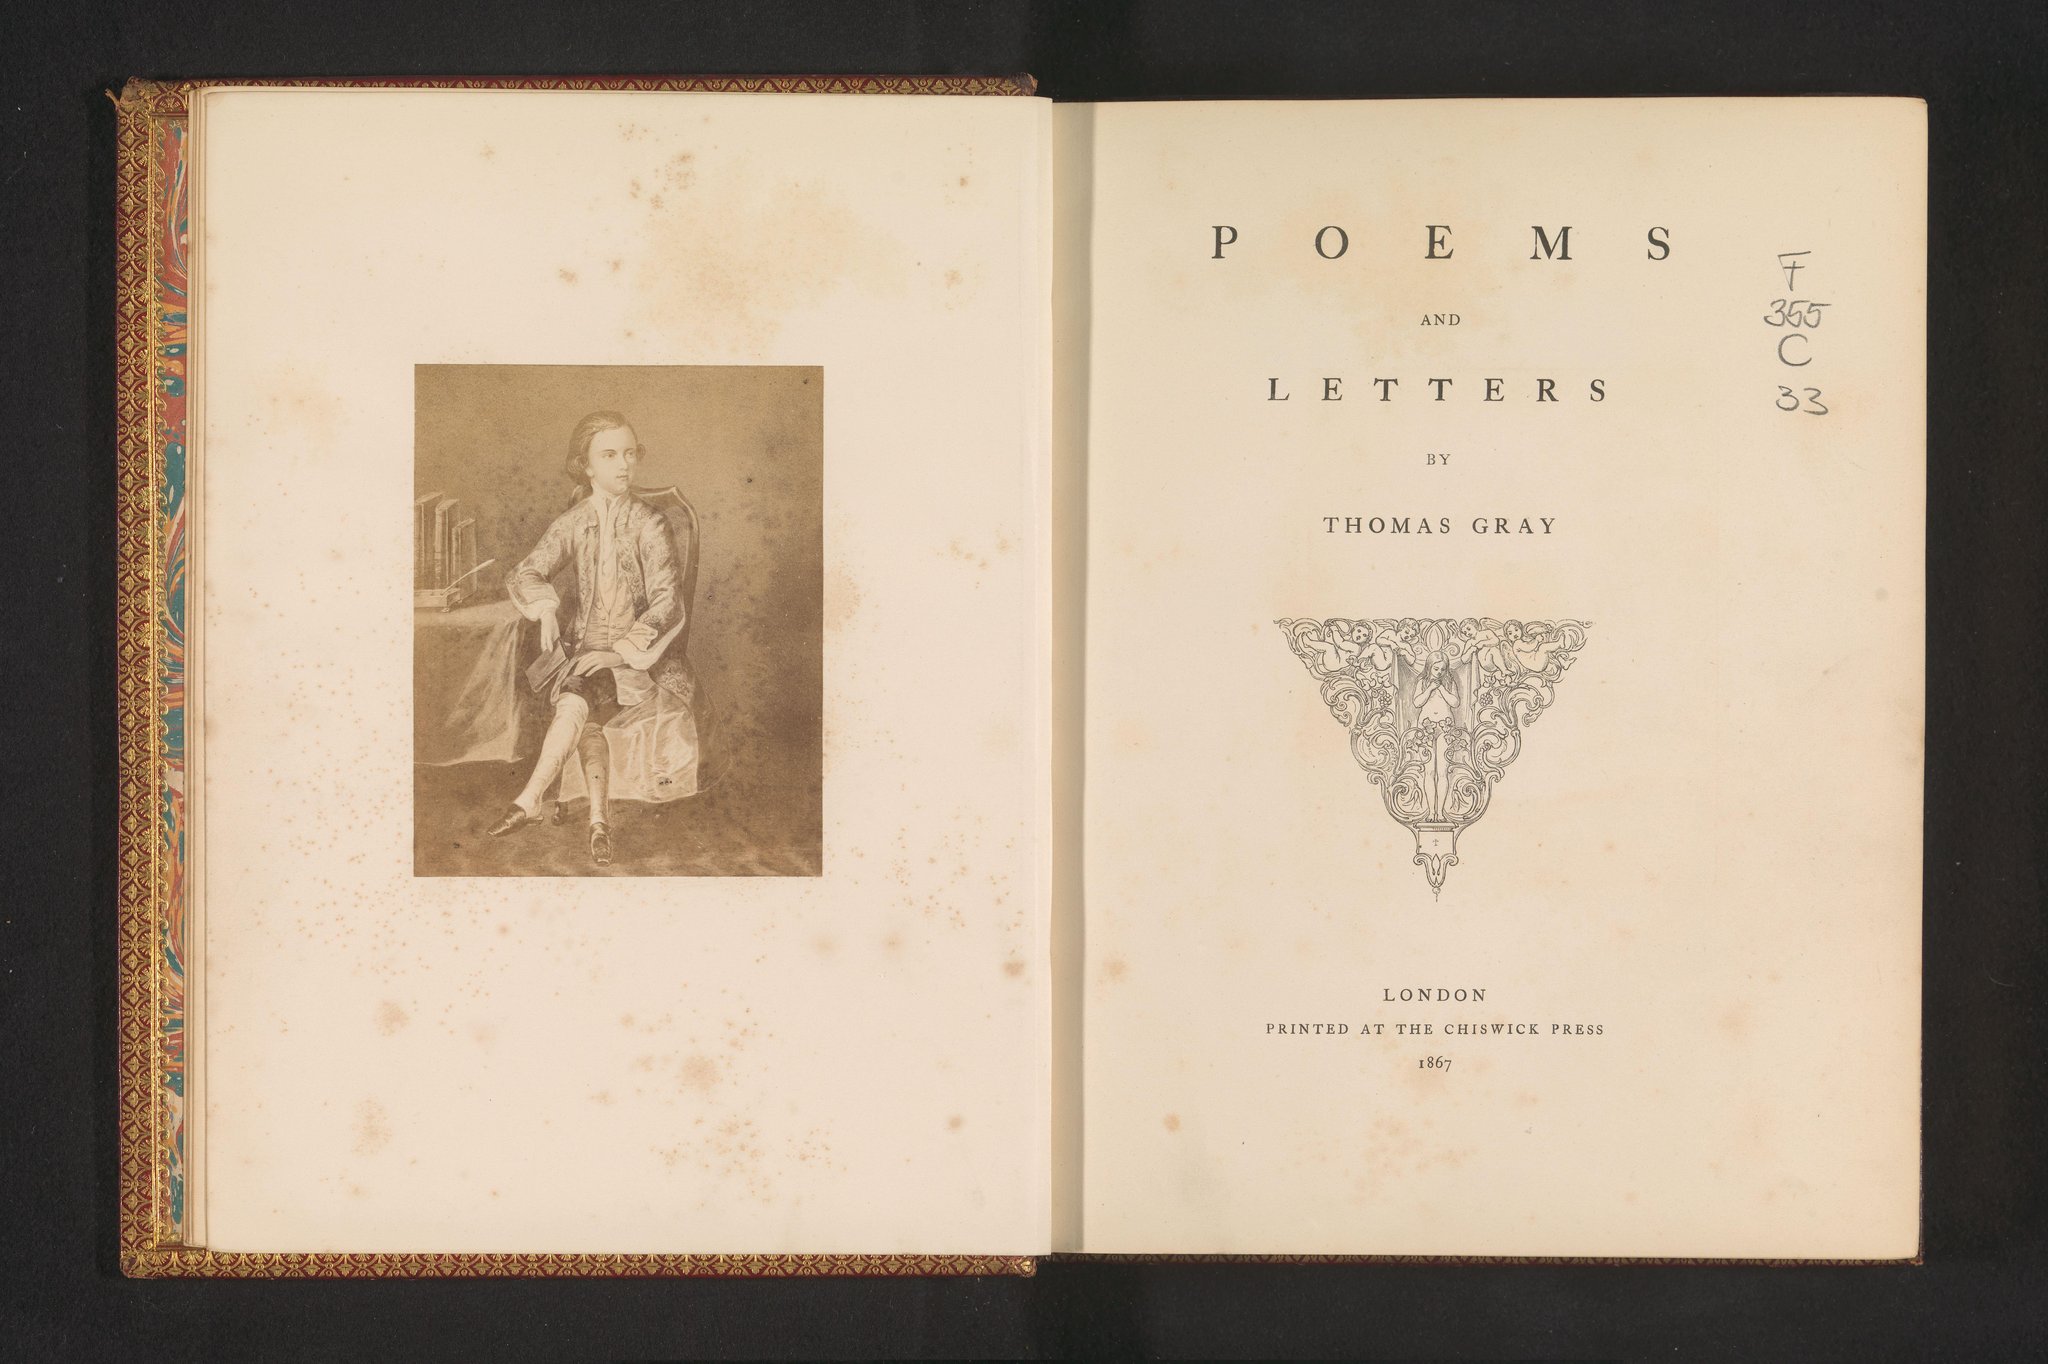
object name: page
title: Fotoreproductie van een schilderij, voorstellende een portret van Thomas Gray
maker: Anonymous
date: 1857-1867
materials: photographic support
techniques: albumen print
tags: thomas gray, portrait of a writer